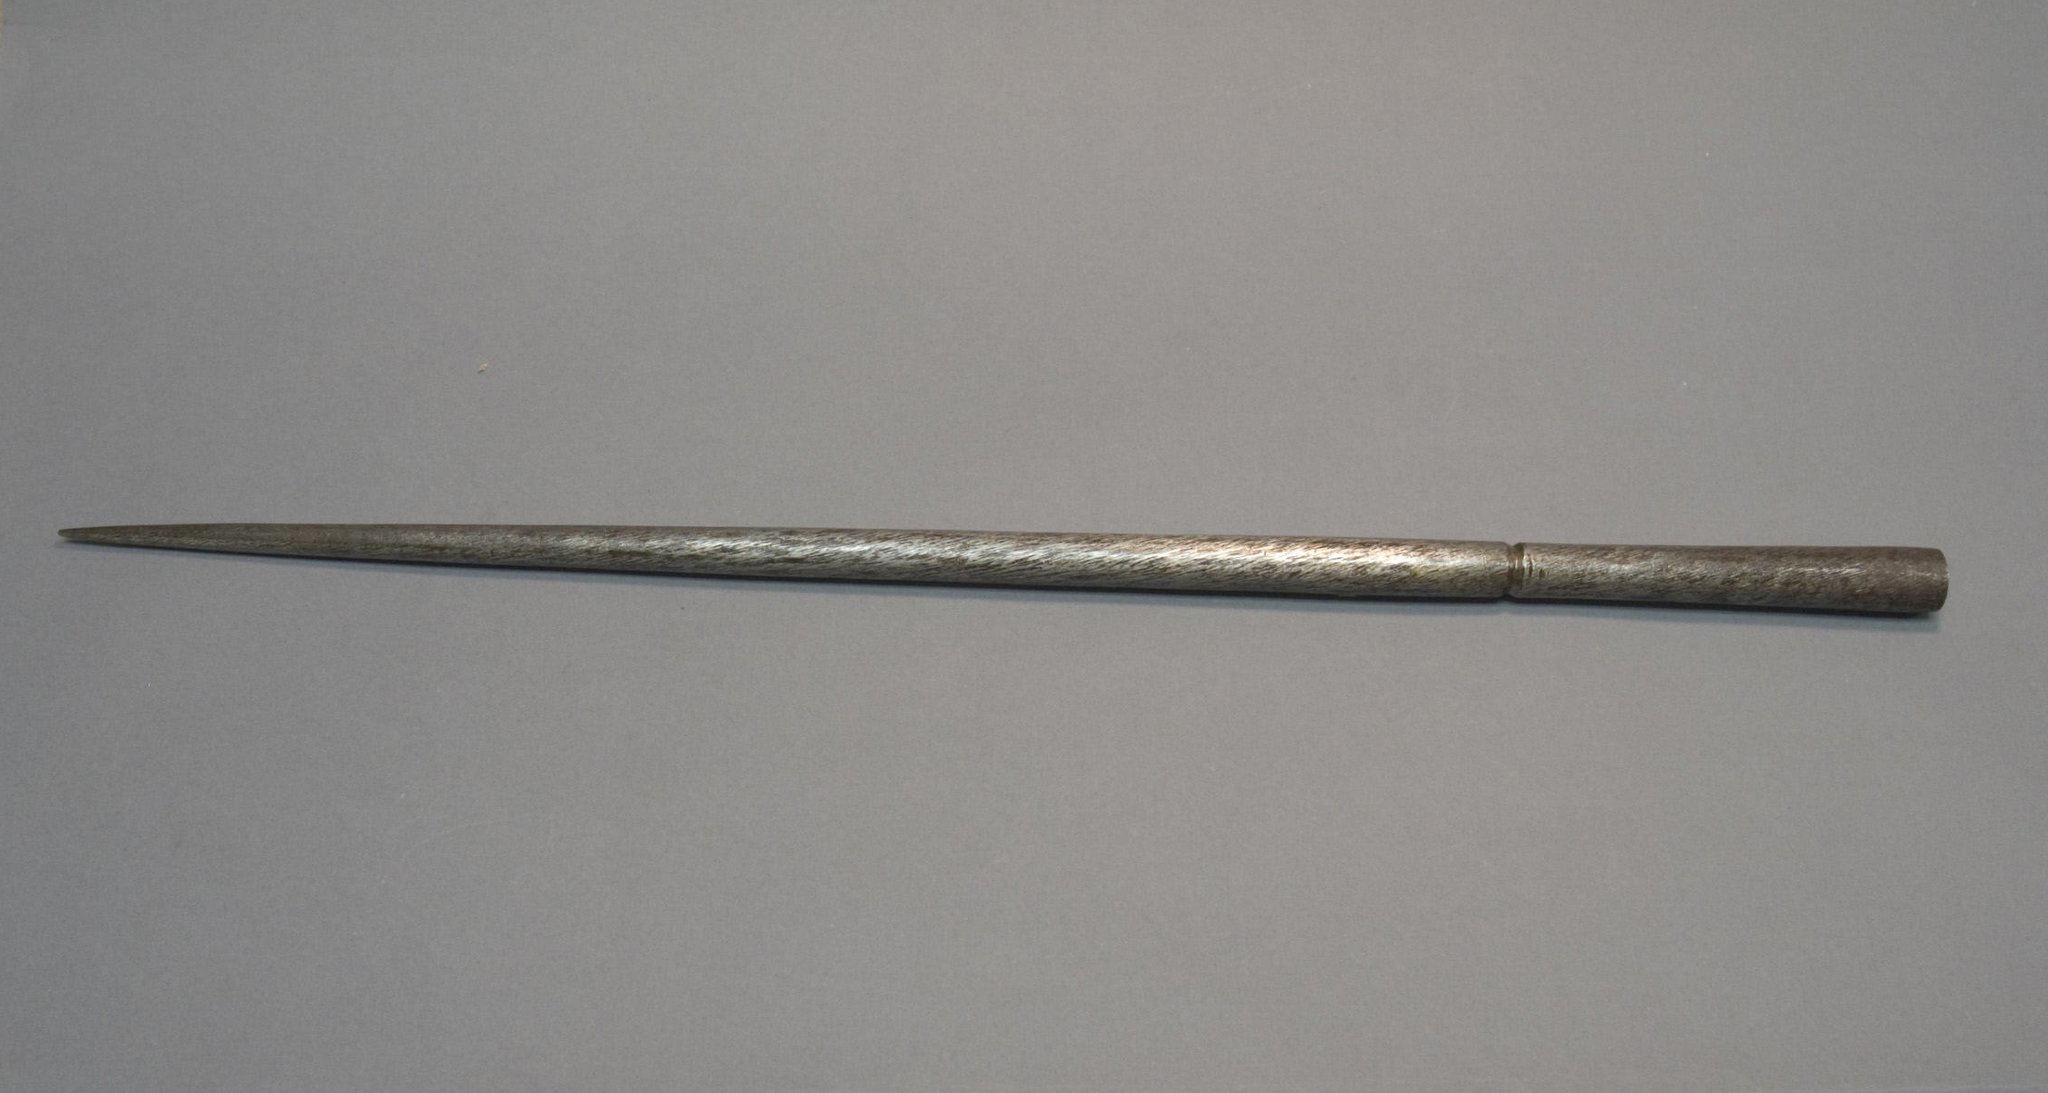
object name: jade carving tool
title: Shaft or mandrel for jade carving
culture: chinese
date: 1901-2000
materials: steel